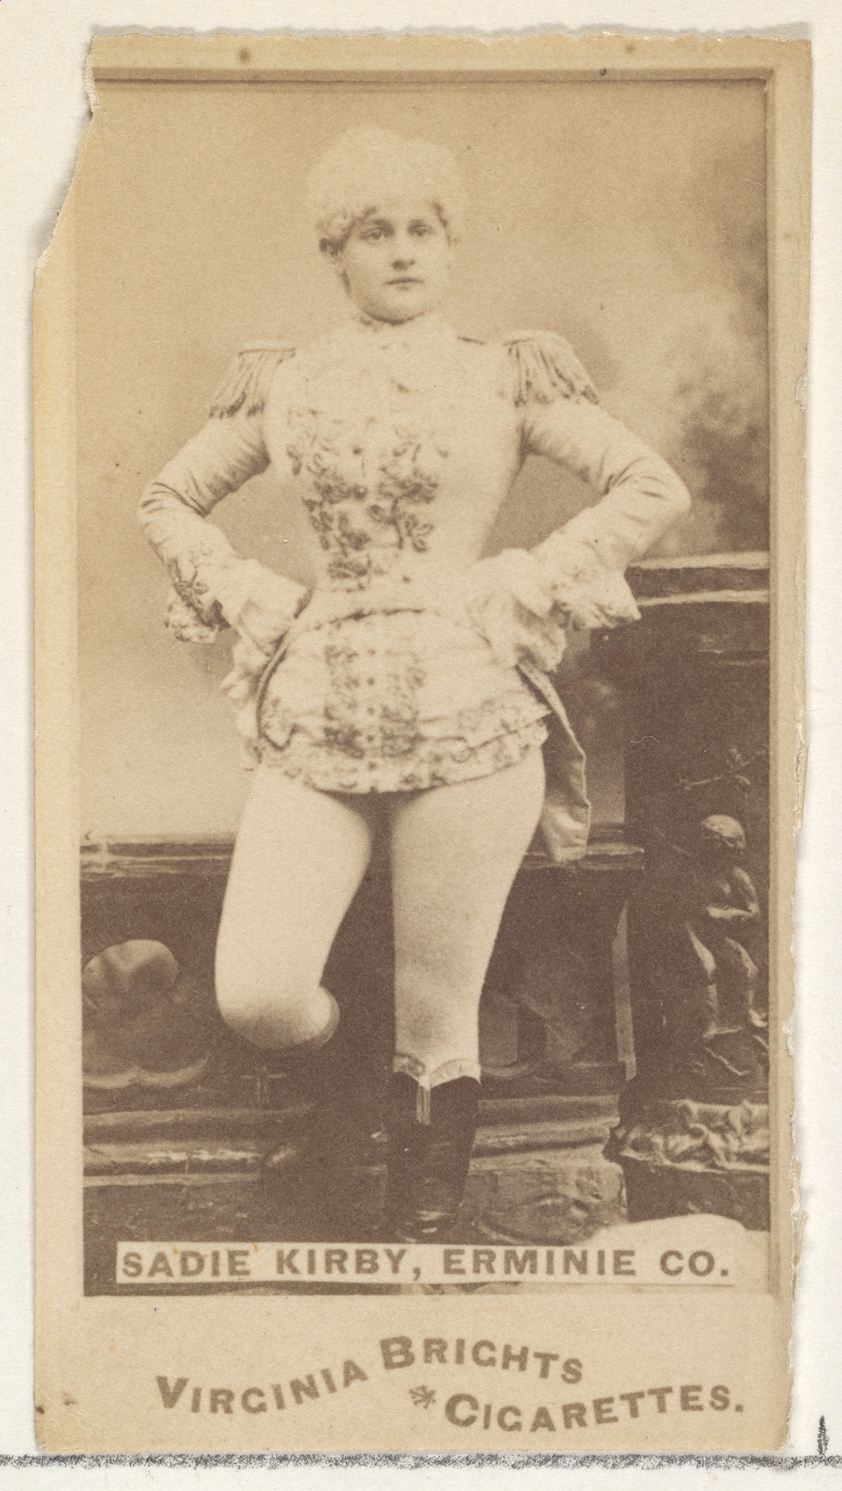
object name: photograph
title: Sadie Kirby, Erminie Co., from the Actors and Actresses series (N45, Type 1) for Virginia Brights Cigarettes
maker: allen & ginter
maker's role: publisher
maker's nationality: american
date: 1888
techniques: albumen silver print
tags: portraits,women,actresses